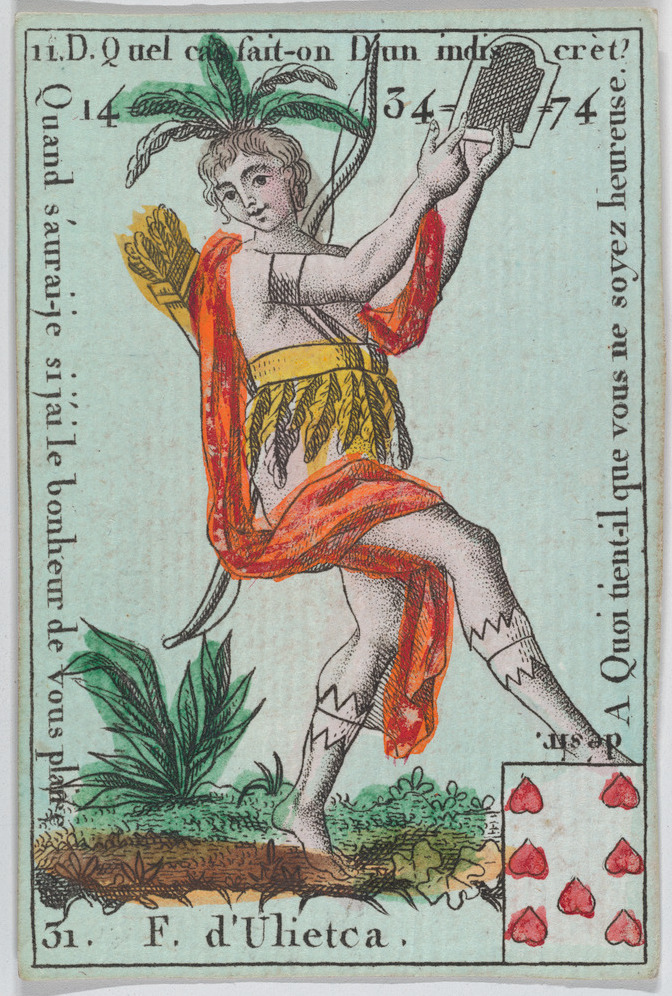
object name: print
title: F. d' Ulietca from playing cards "Jeu d'Or"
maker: anonymous, french, 18th century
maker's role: artist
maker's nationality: french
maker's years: 1700-1800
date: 1700-1799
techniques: etching, hand coloring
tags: bow and arrow,men,portraits,playing cards